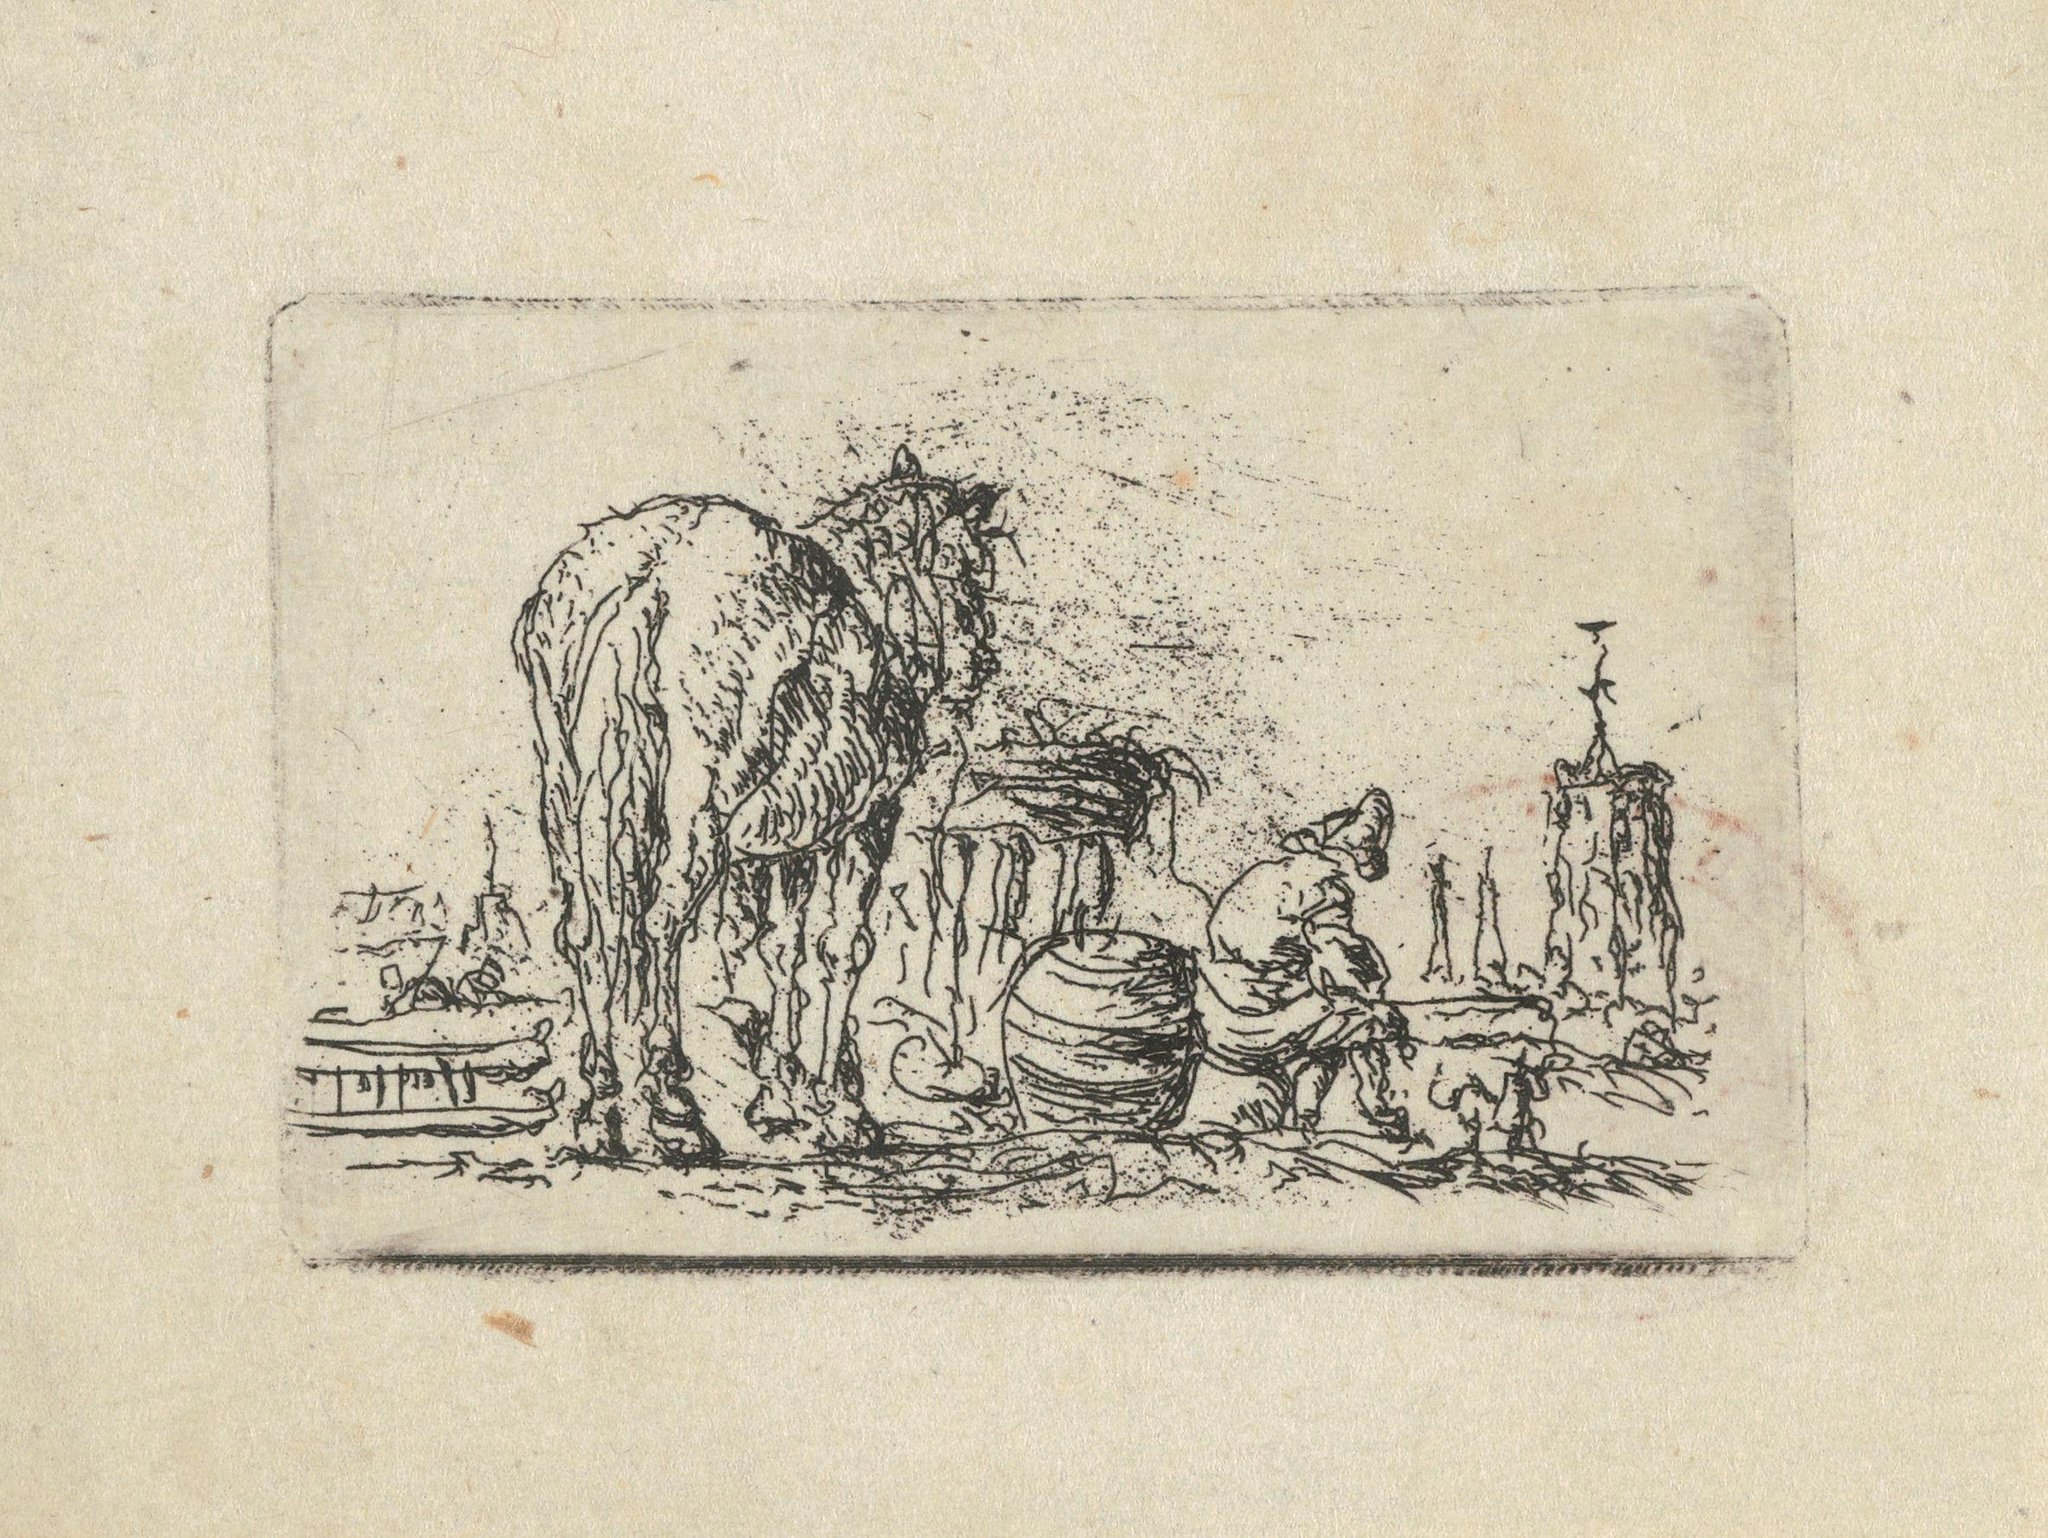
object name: print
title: Man zittend naast ton en staand paard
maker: Anonymous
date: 1600-1700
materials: paper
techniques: etching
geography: netherlands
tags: horse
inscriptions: collector's mark: Lugt 240